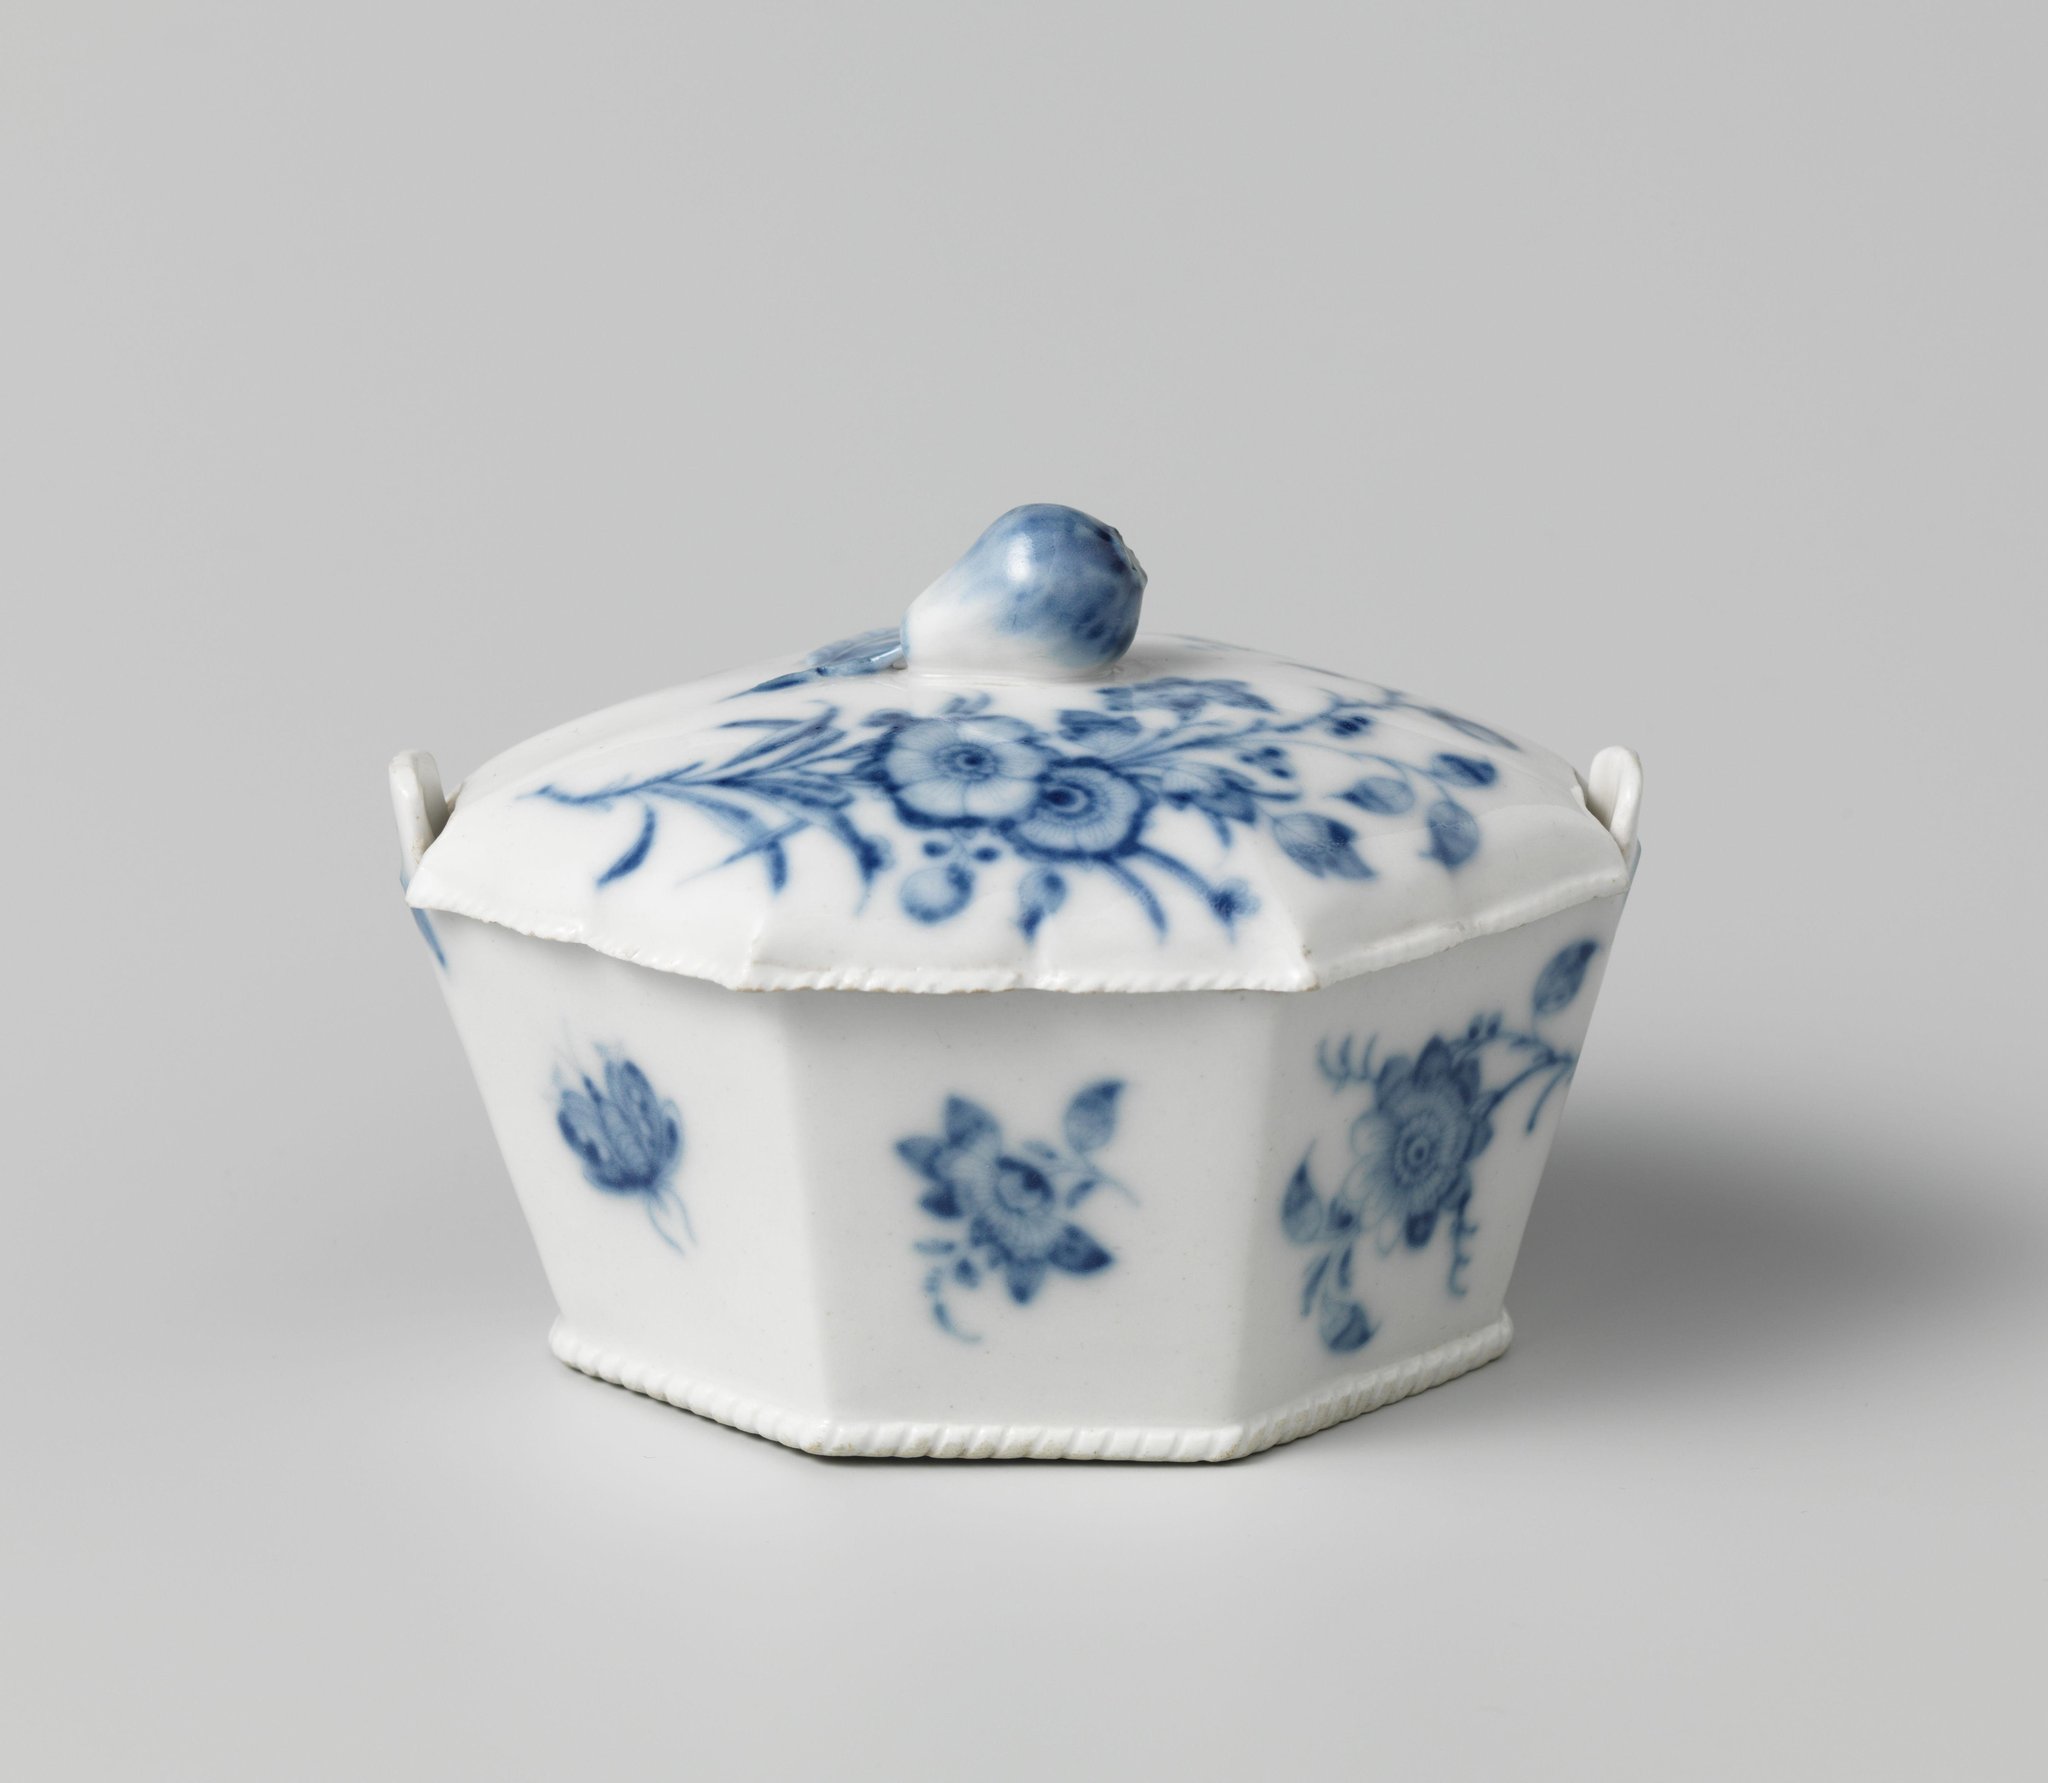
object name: butter dish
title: Botervloot, beschilderd met bloemtakken en vlinders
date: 1778-1782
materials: porcelain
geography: loosdrecht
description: Botervloot van porselein. Langs de voetrand een koordmotief in reliëf. Een vrucht met takje en blad als dekselknop. Beschilderd in onderglazuurblauw met bloemtakken en vlinders.